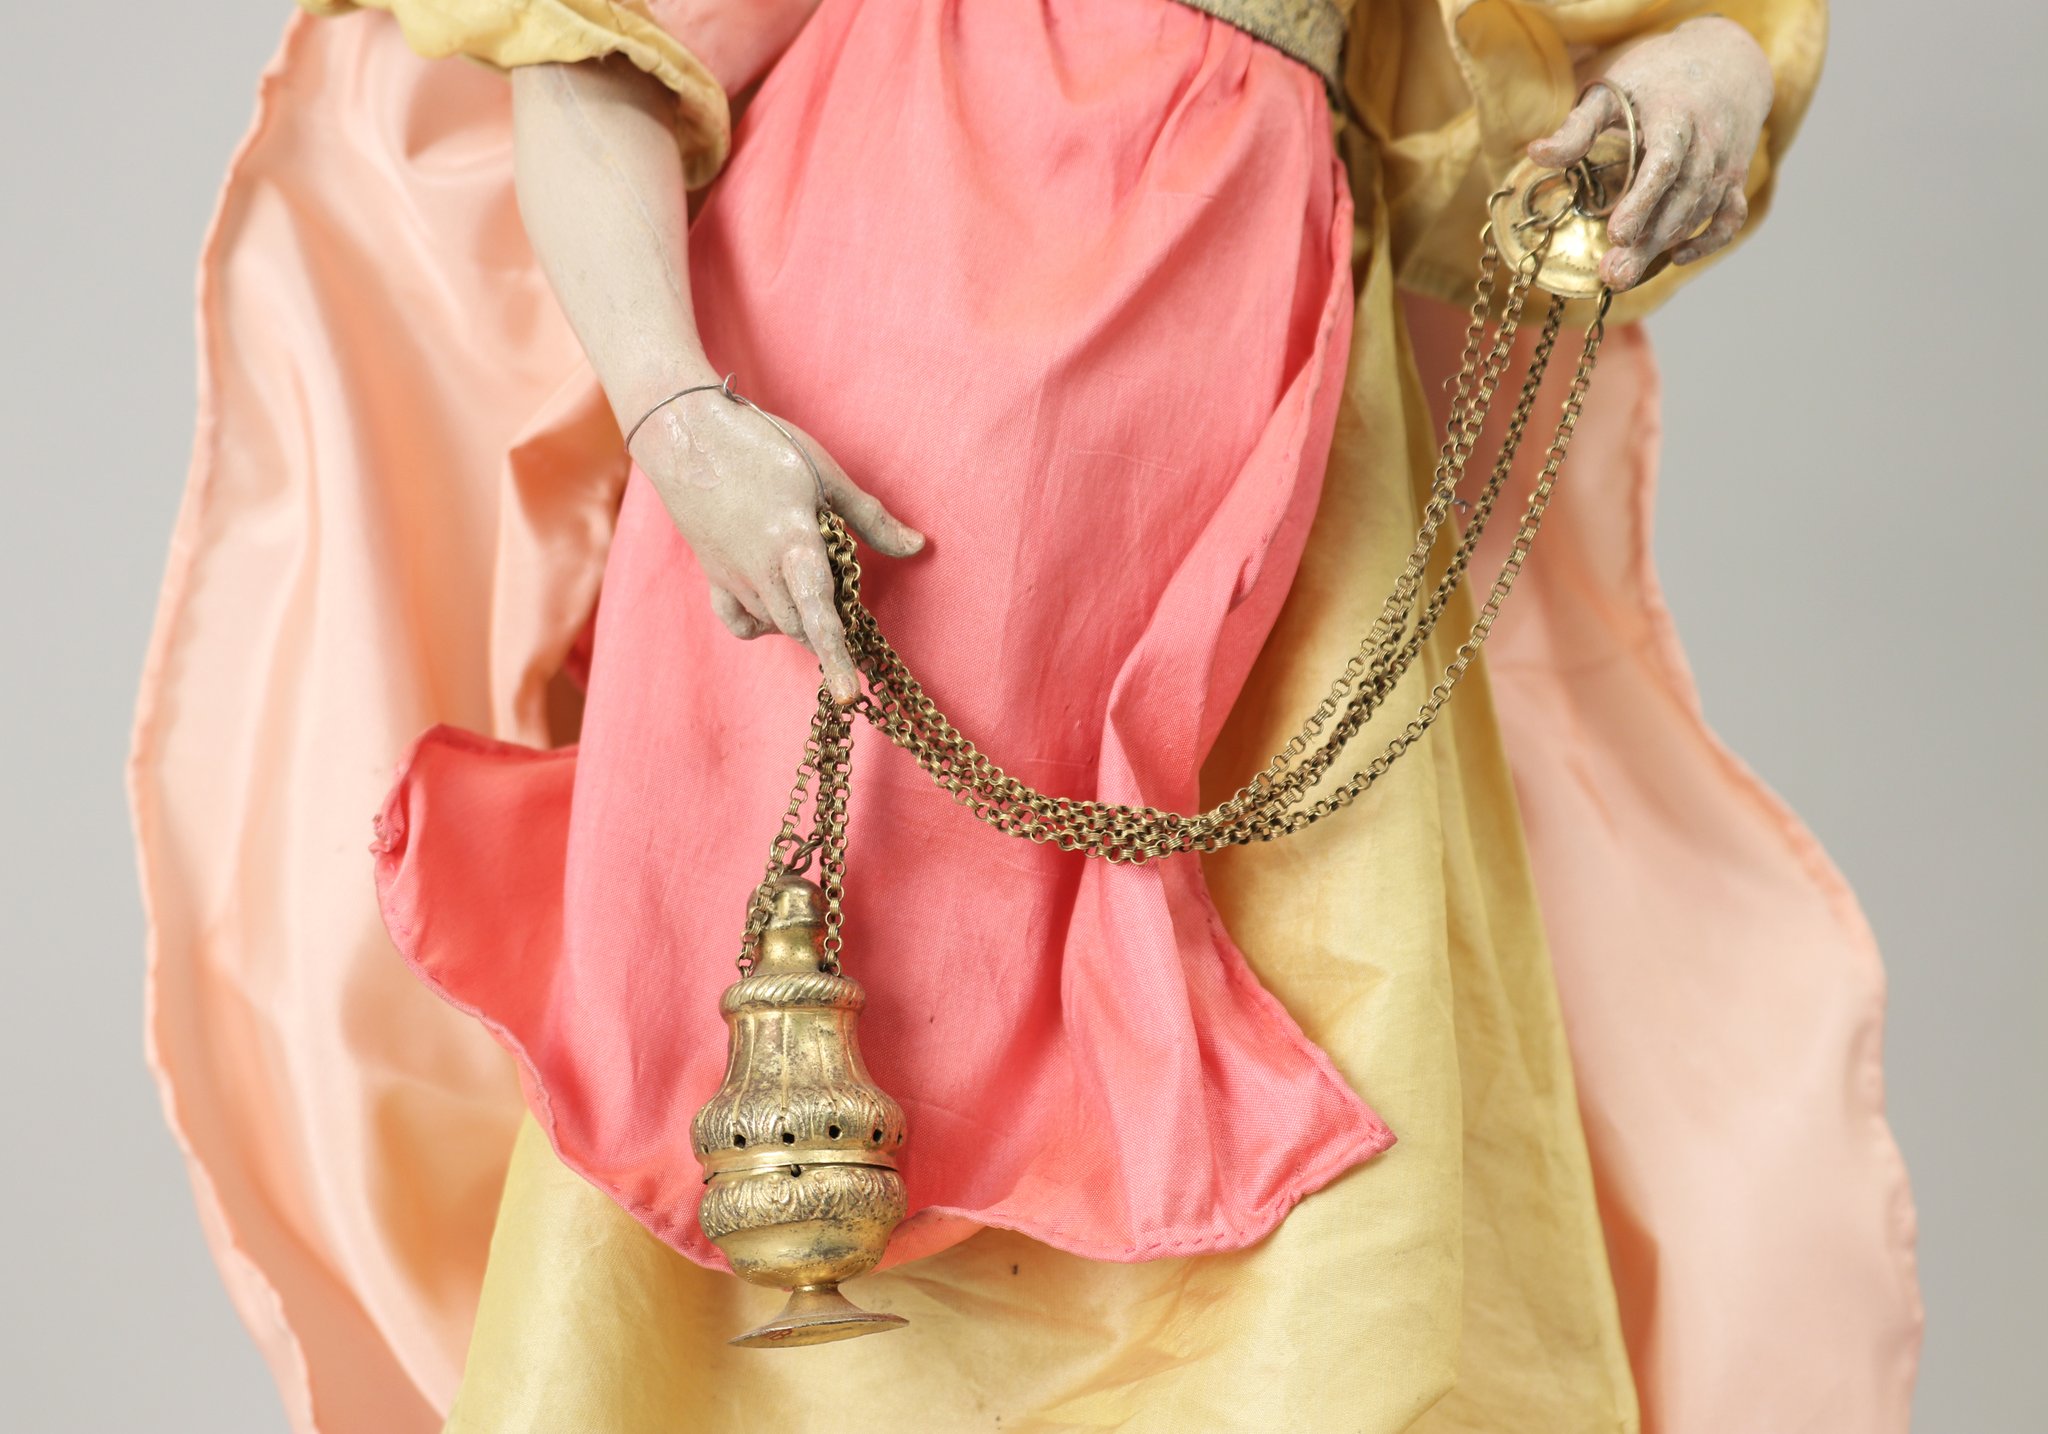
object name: crèche figure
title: Censer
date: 1751-1800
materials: silver gilt